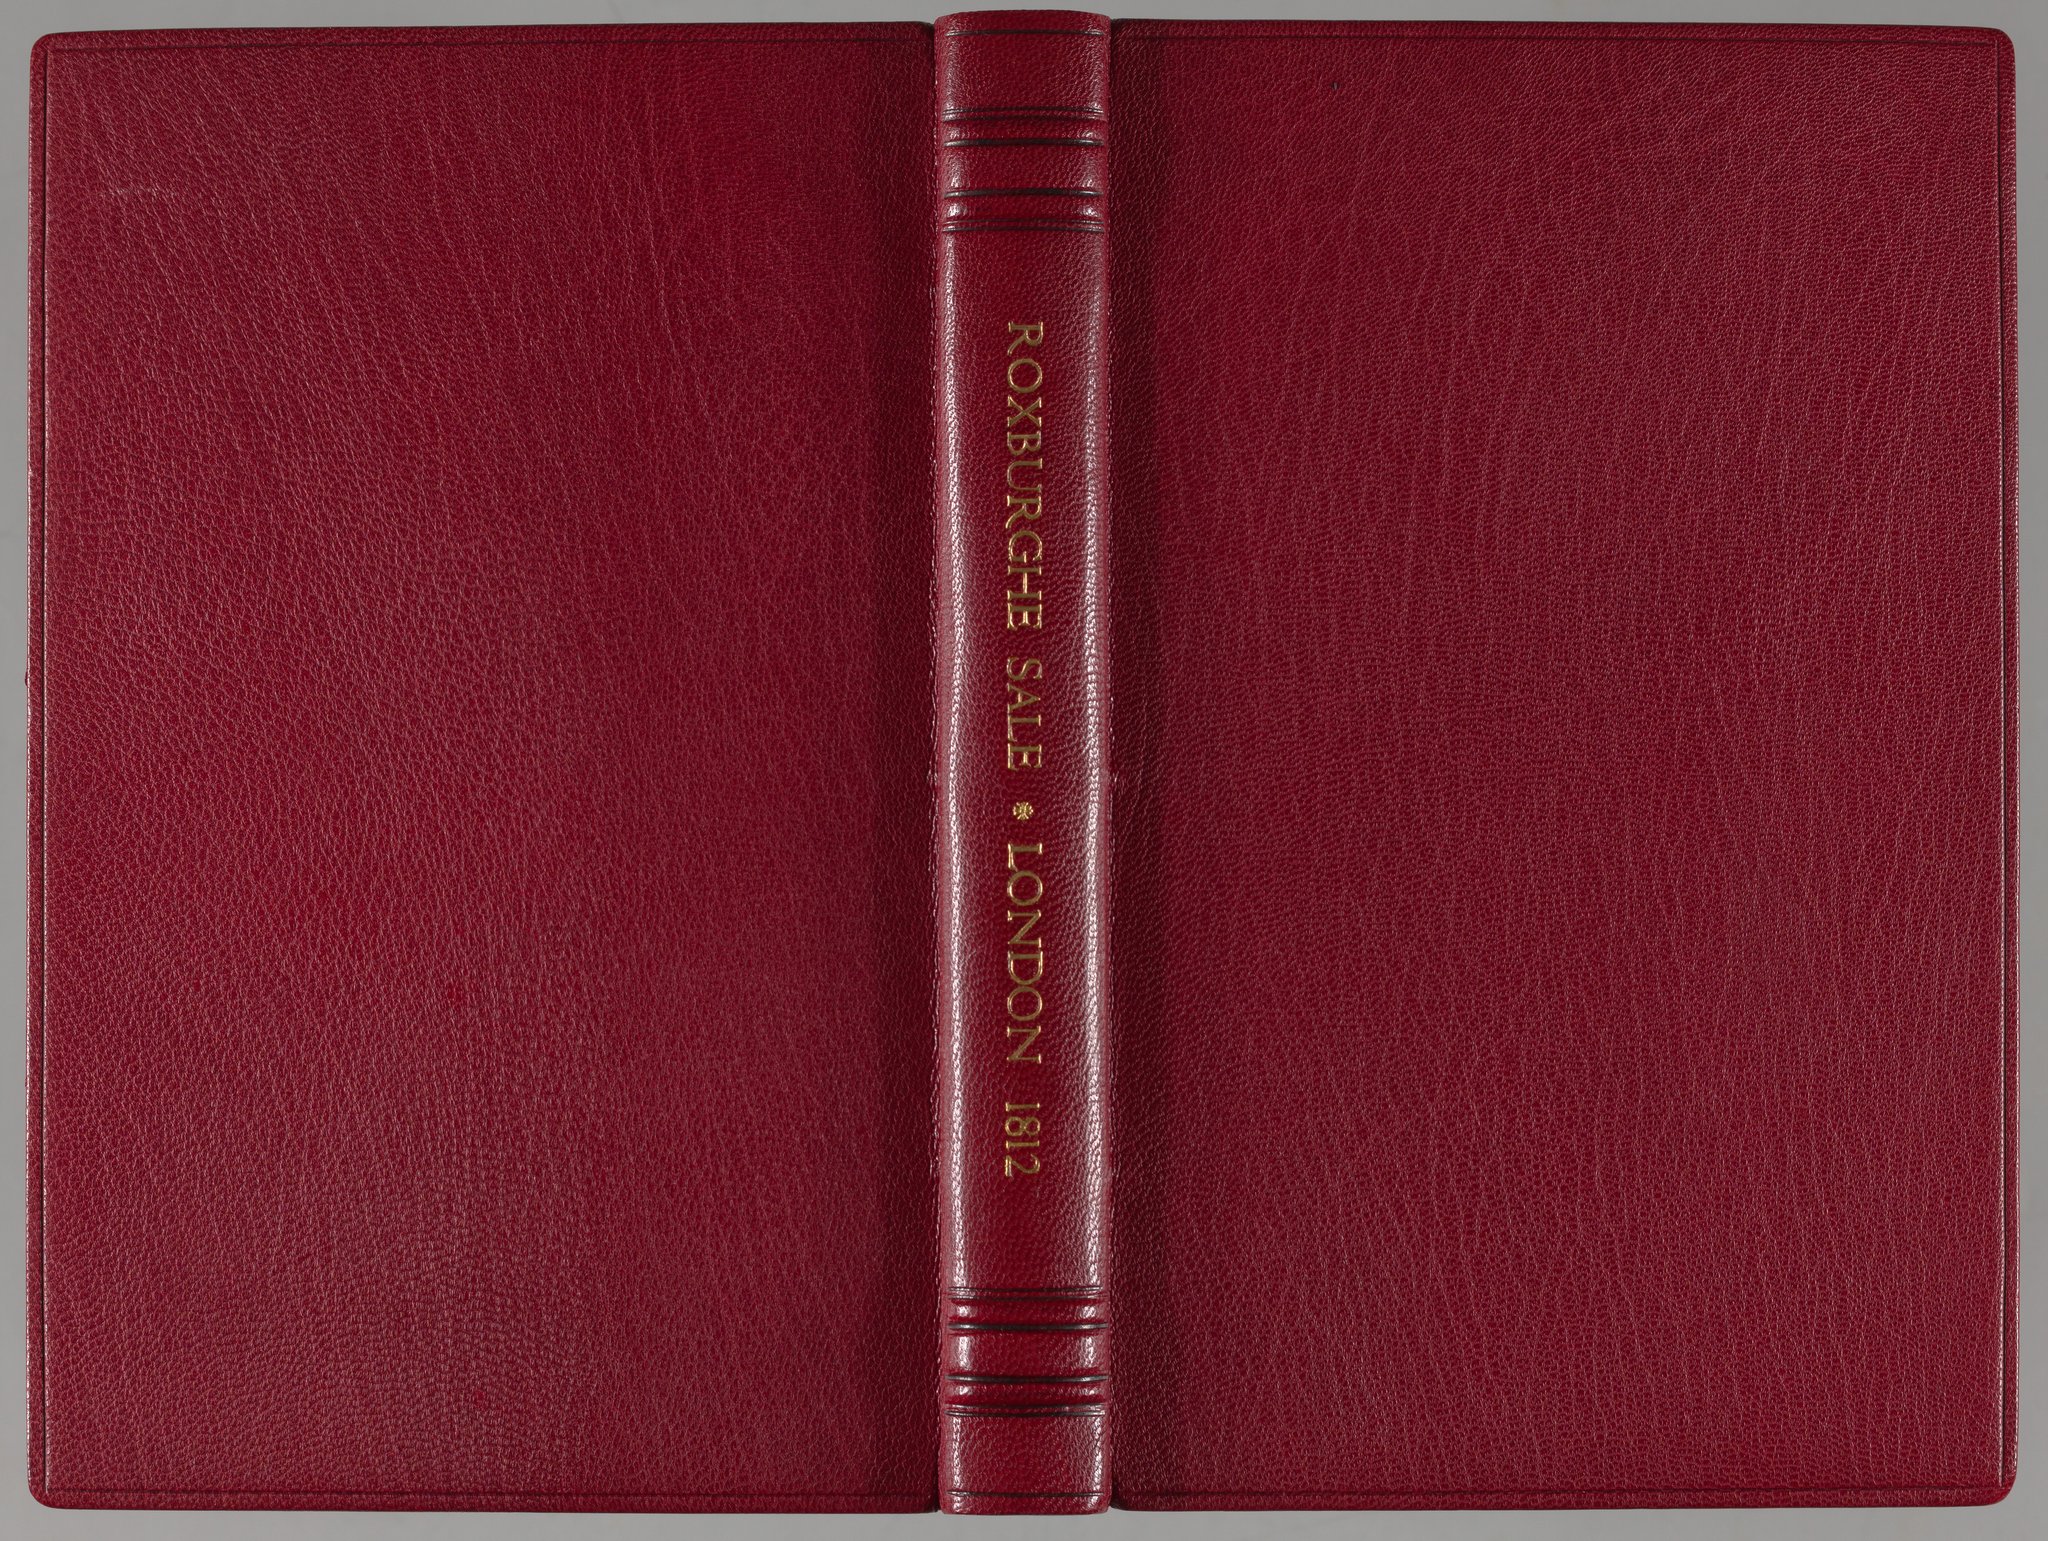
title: A catalogue of the library of the late John, Duke of Roxburghe : arranged by G. and W. Nicol ; which will be sold by auction ... on Monday, 18th May, 1812, and the forty-one following days, Sundays excepted ... by Robert H. Evans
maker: robert harding evans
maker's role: author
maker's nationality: british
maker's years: 1778-1857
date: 1812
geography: england